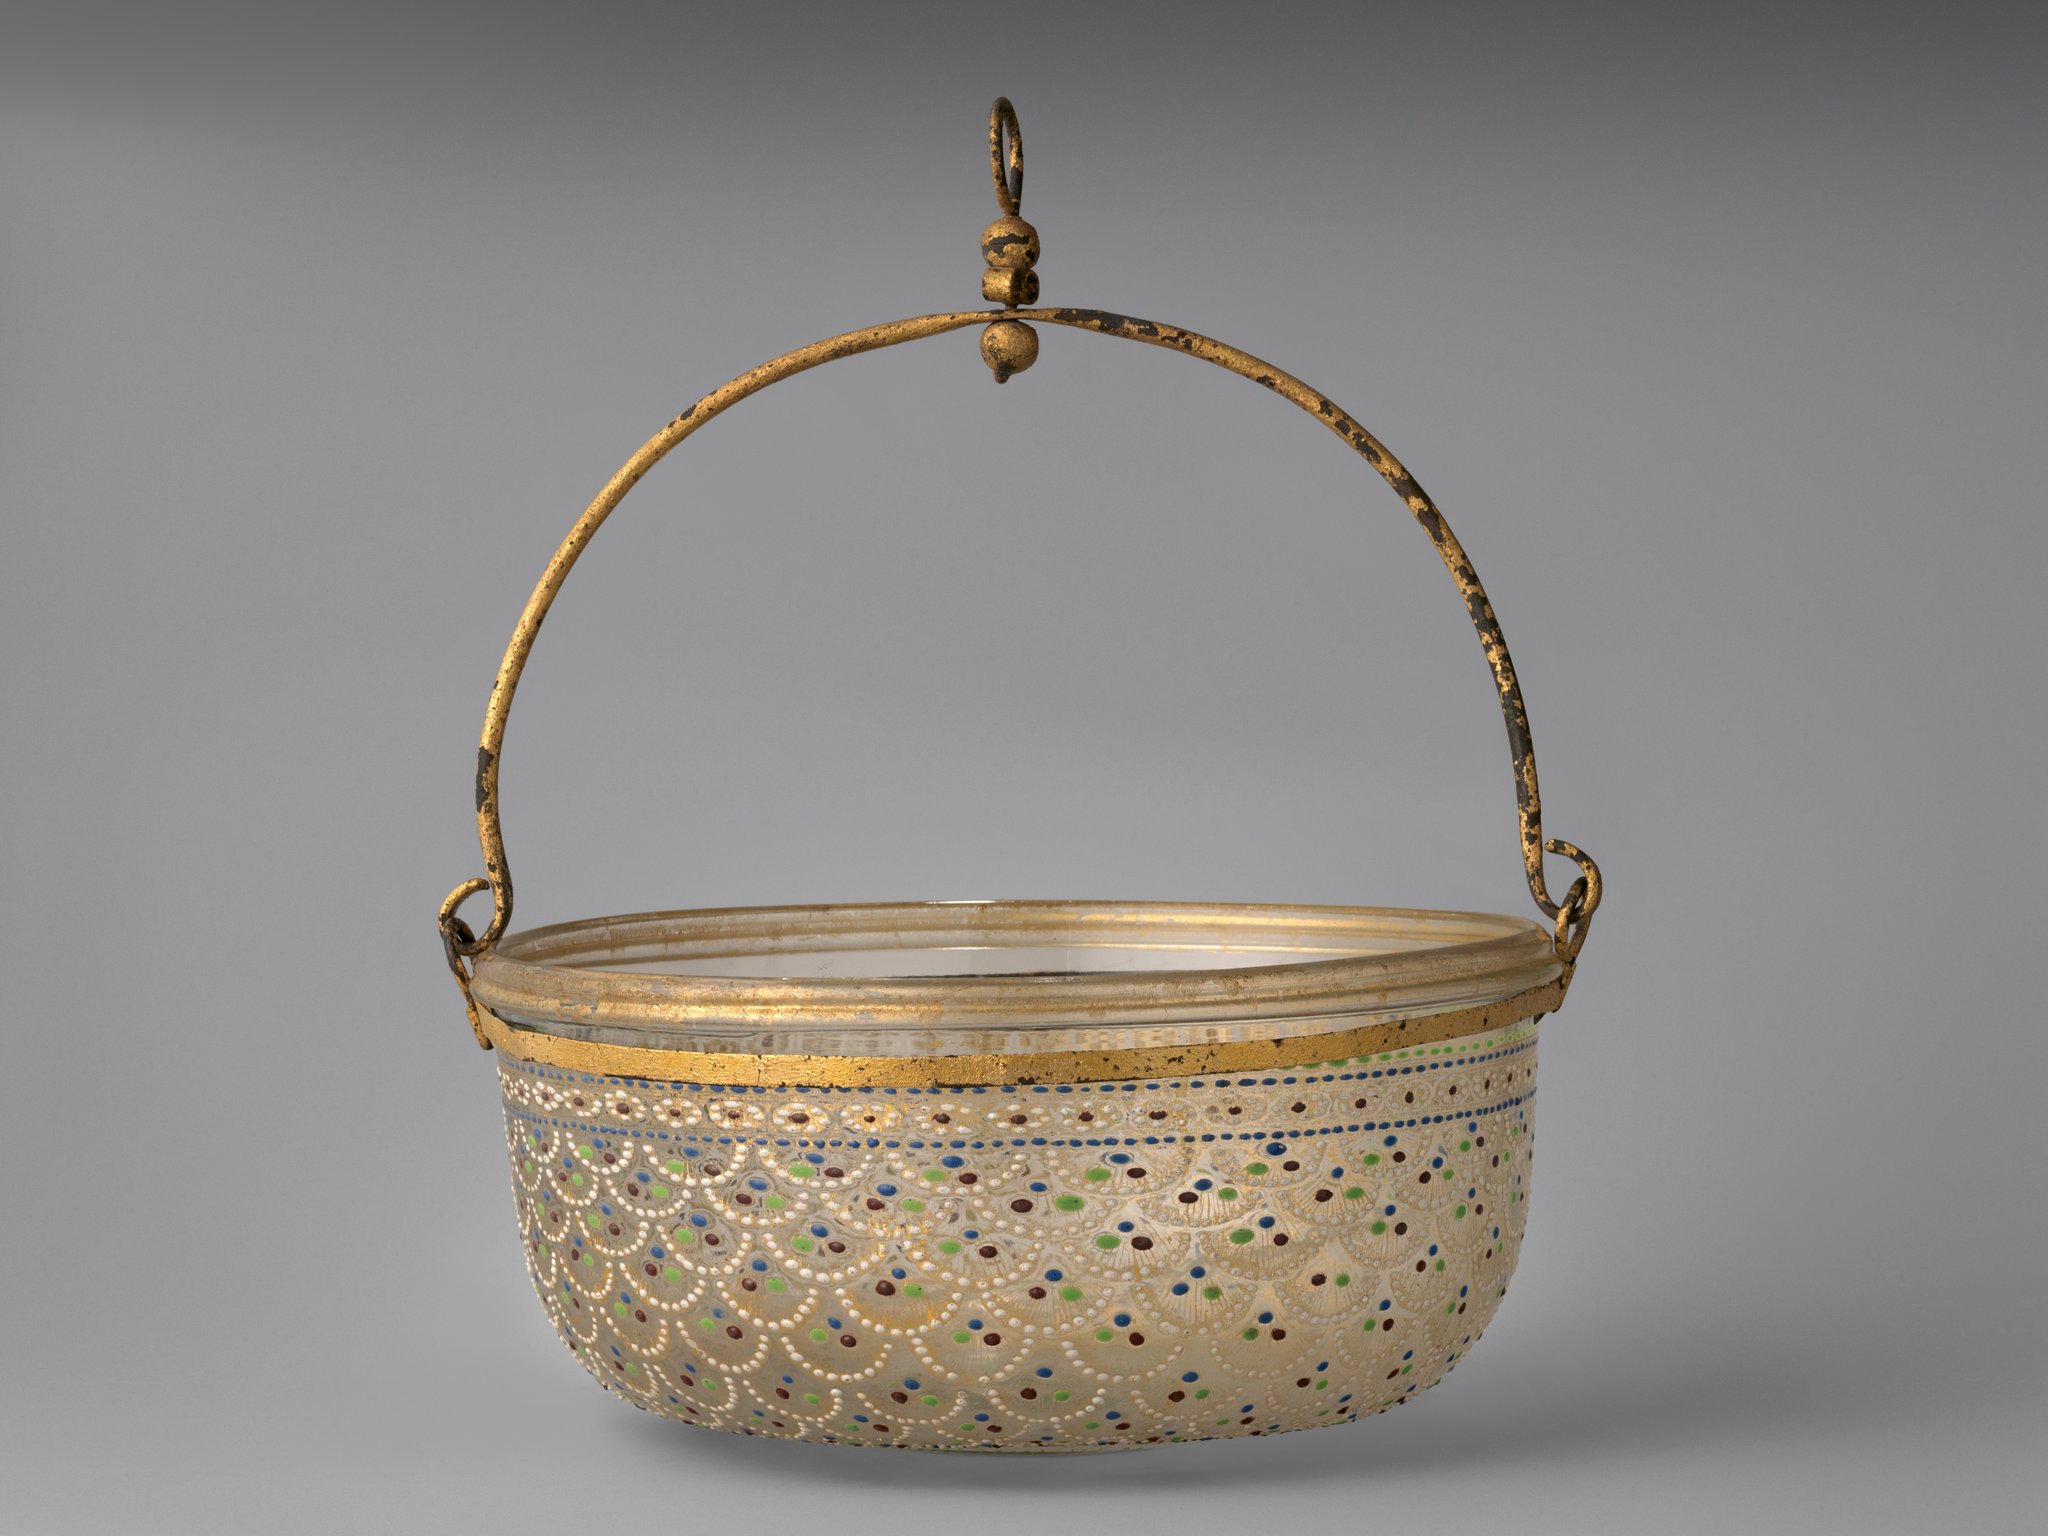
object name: pail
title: Pail (Situla)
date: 1501-1533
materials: gilt, glass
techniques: enamel